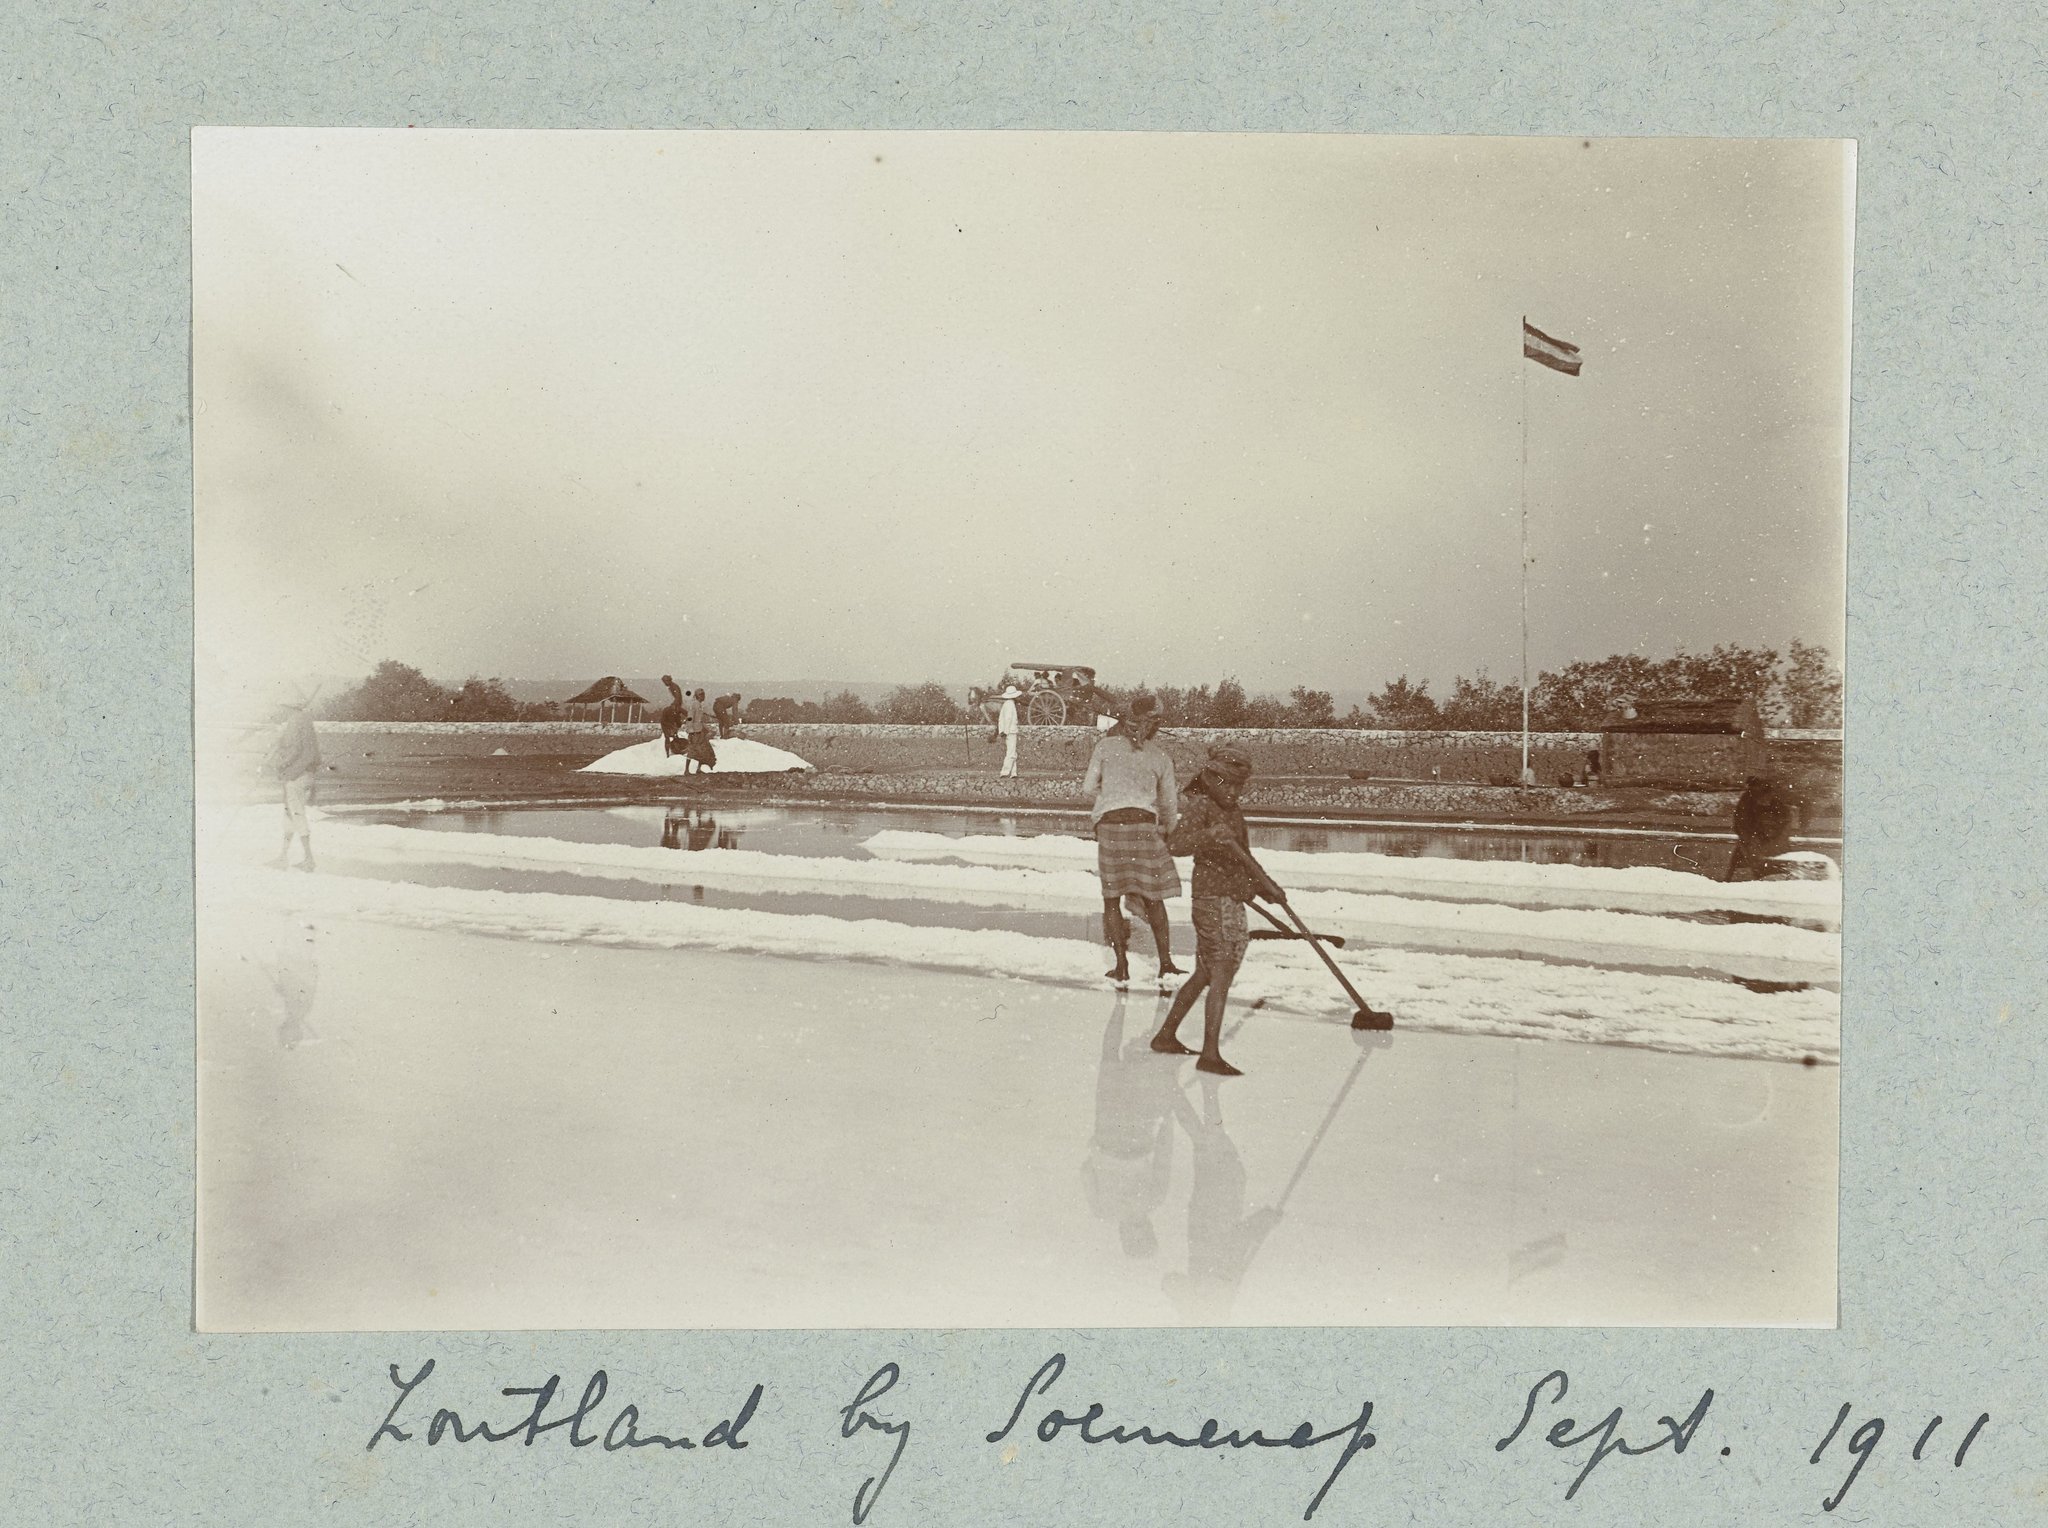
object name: photograph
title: Zoutland bij Soemenep Sept 1911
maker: frits freerks fontein fz.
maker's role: fotograaf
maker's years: 1882-1928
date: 1910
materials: cardboard, paper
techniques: gelatin silver print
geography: madura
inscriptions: caption: ‘Zoutland bij Soemenep Sept 1911’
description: Een aantal Indonesische kinderen loopt op blote voeten door het zout houdende water en vegen het zout uit het sterk geconcentreerde water op hopen. Foto uit album 'Photographieën".